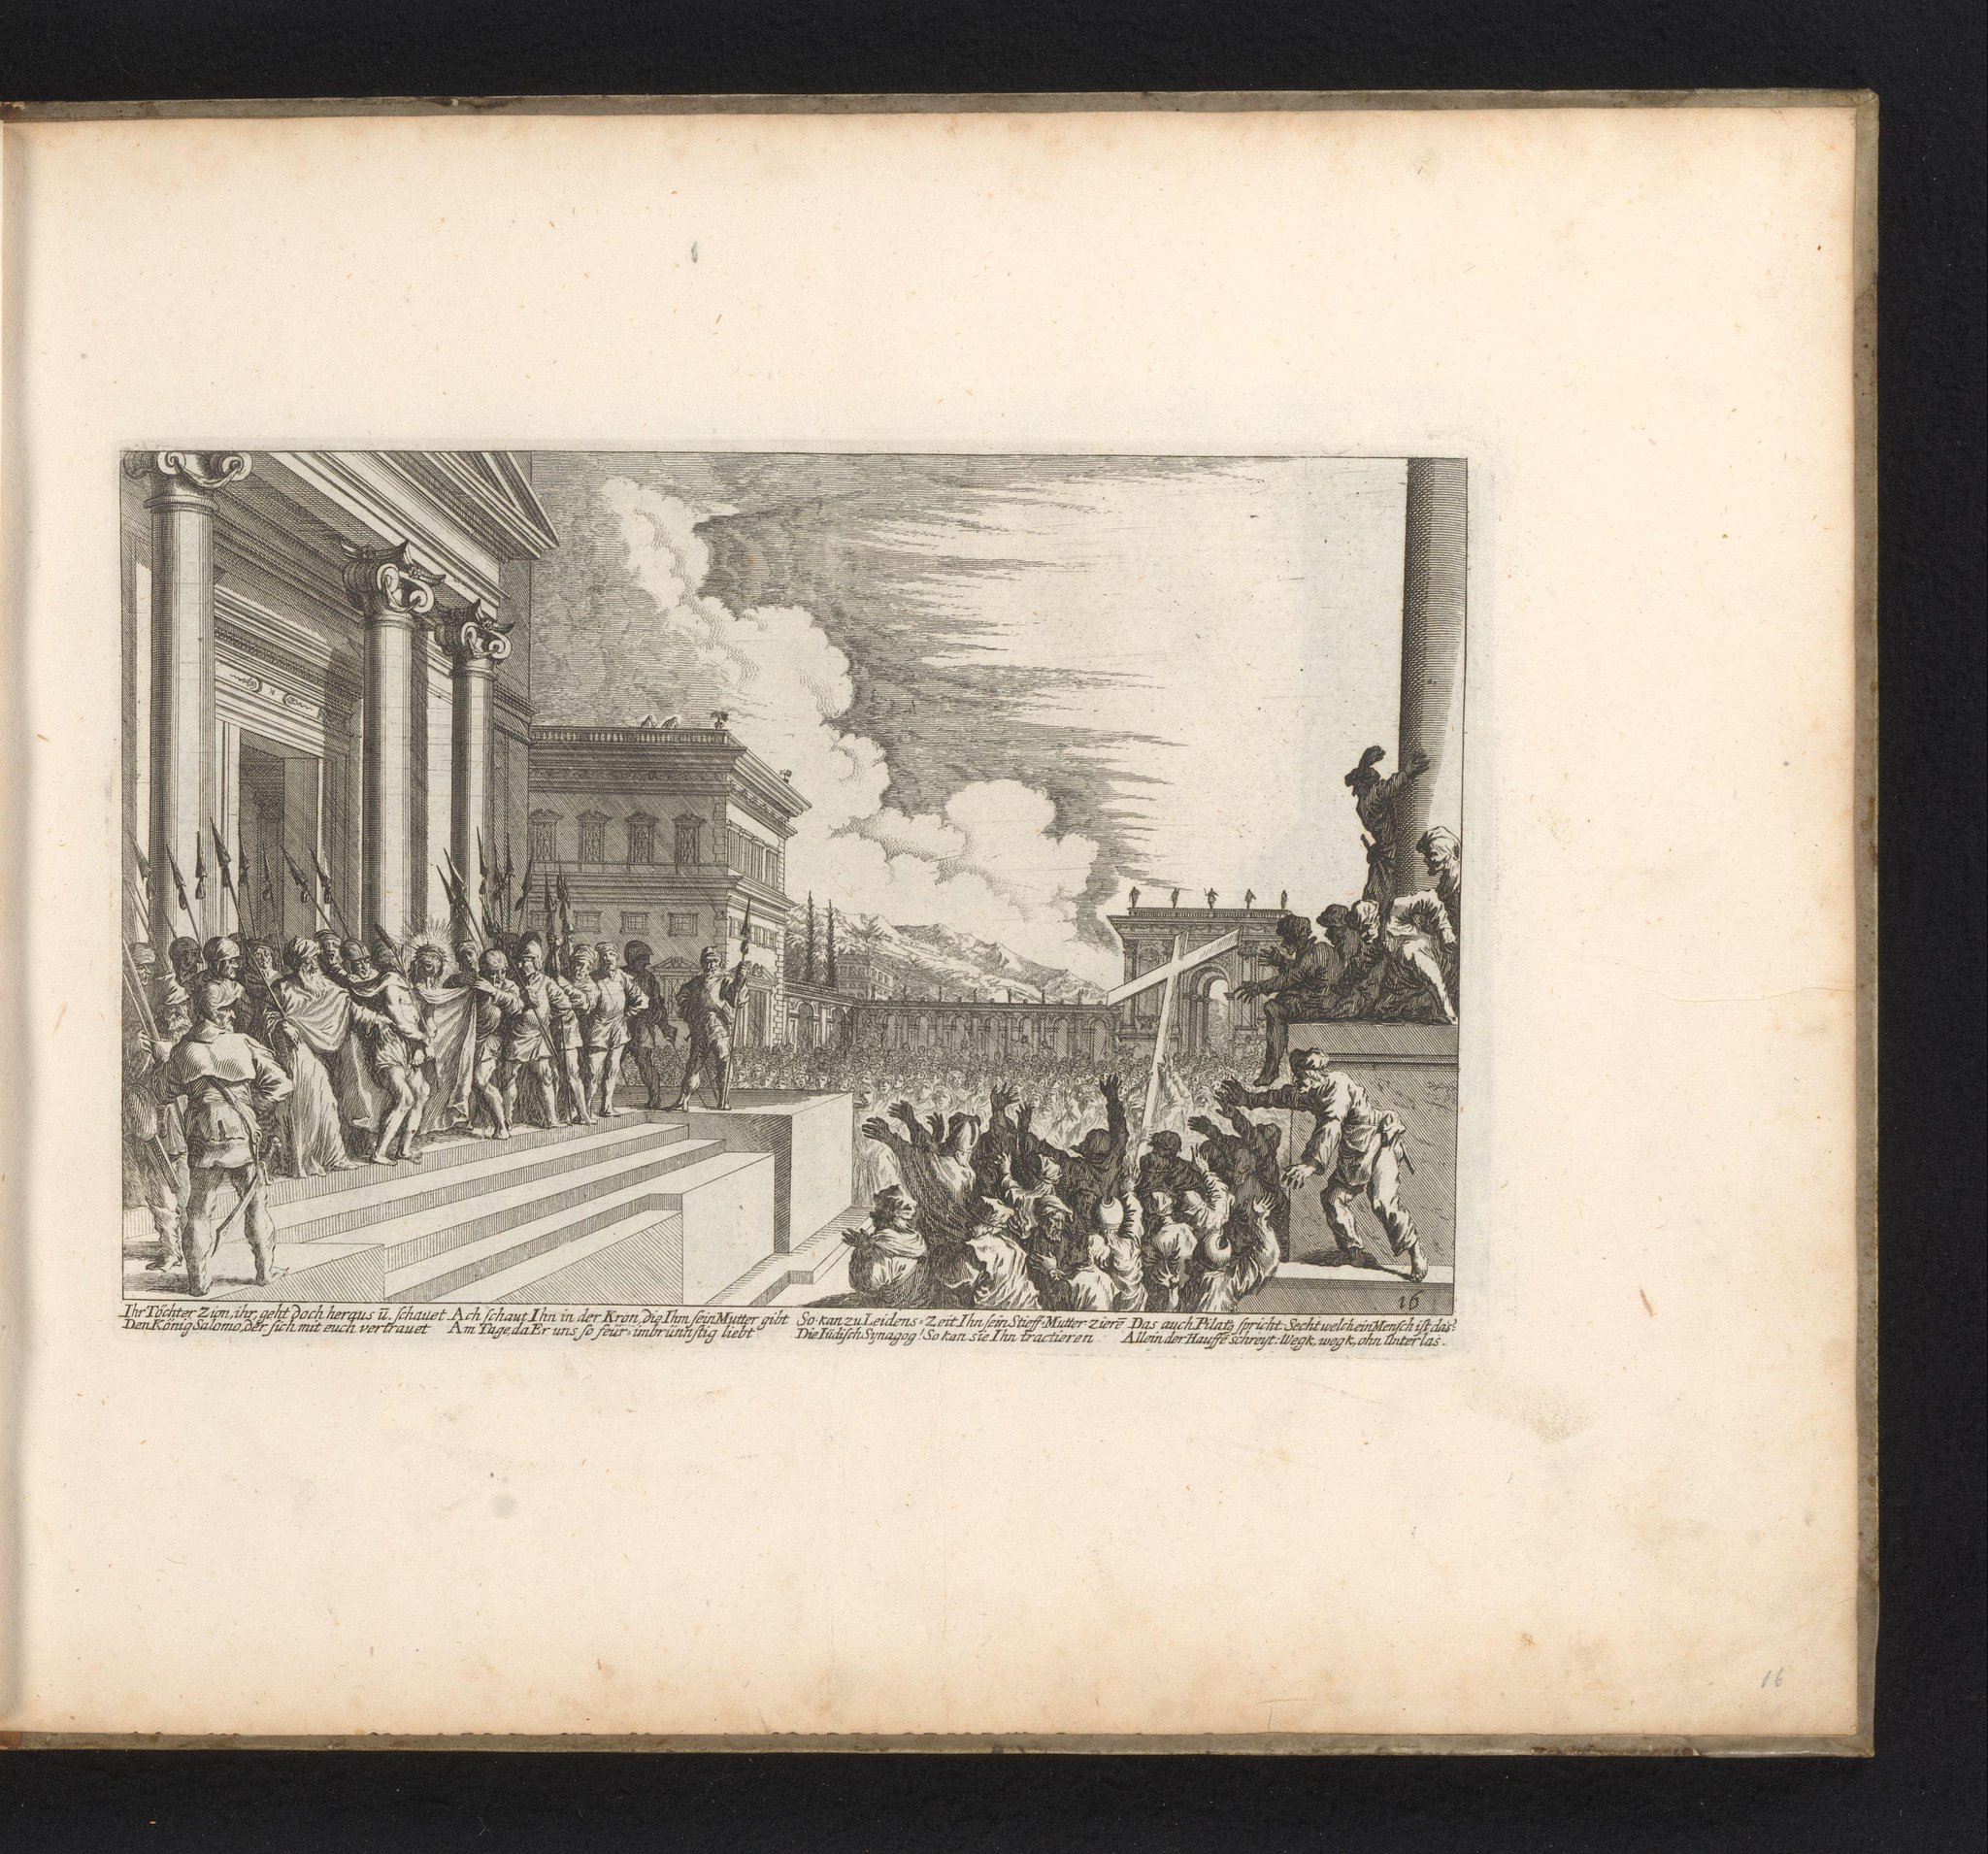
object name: print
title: Christus aan het volk getoond (Ecce Homo)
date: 1670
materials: paper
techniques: etching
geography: augsburg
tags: pilate showing christ to the people, 'ostentatio christi', 'ecce homo' (john 19:4-6)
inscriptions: collector's mark: Lugt 2228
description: Tekst in het Duits in de ondermarge. Rechtsonder genummerd: 16. Prent maakt deel uit van een album.